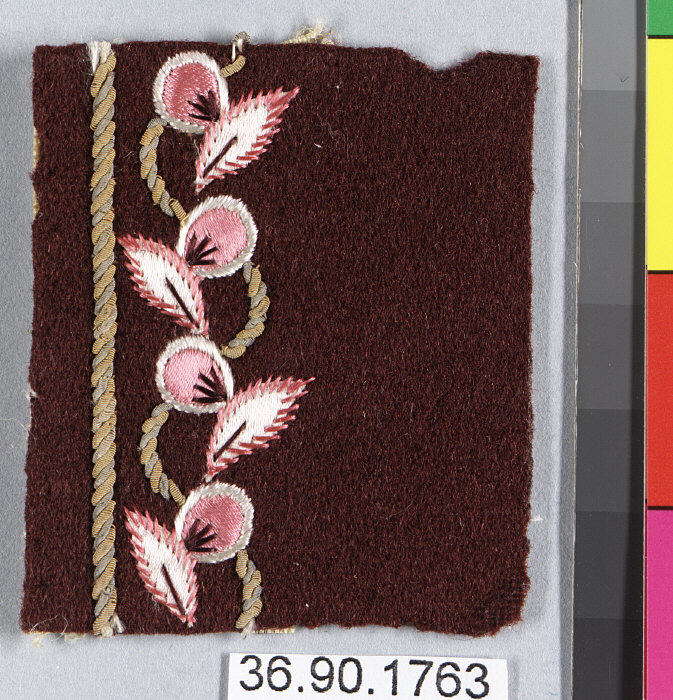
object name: sample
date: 1801-1833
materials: felt, metal thread, silk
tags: flowers